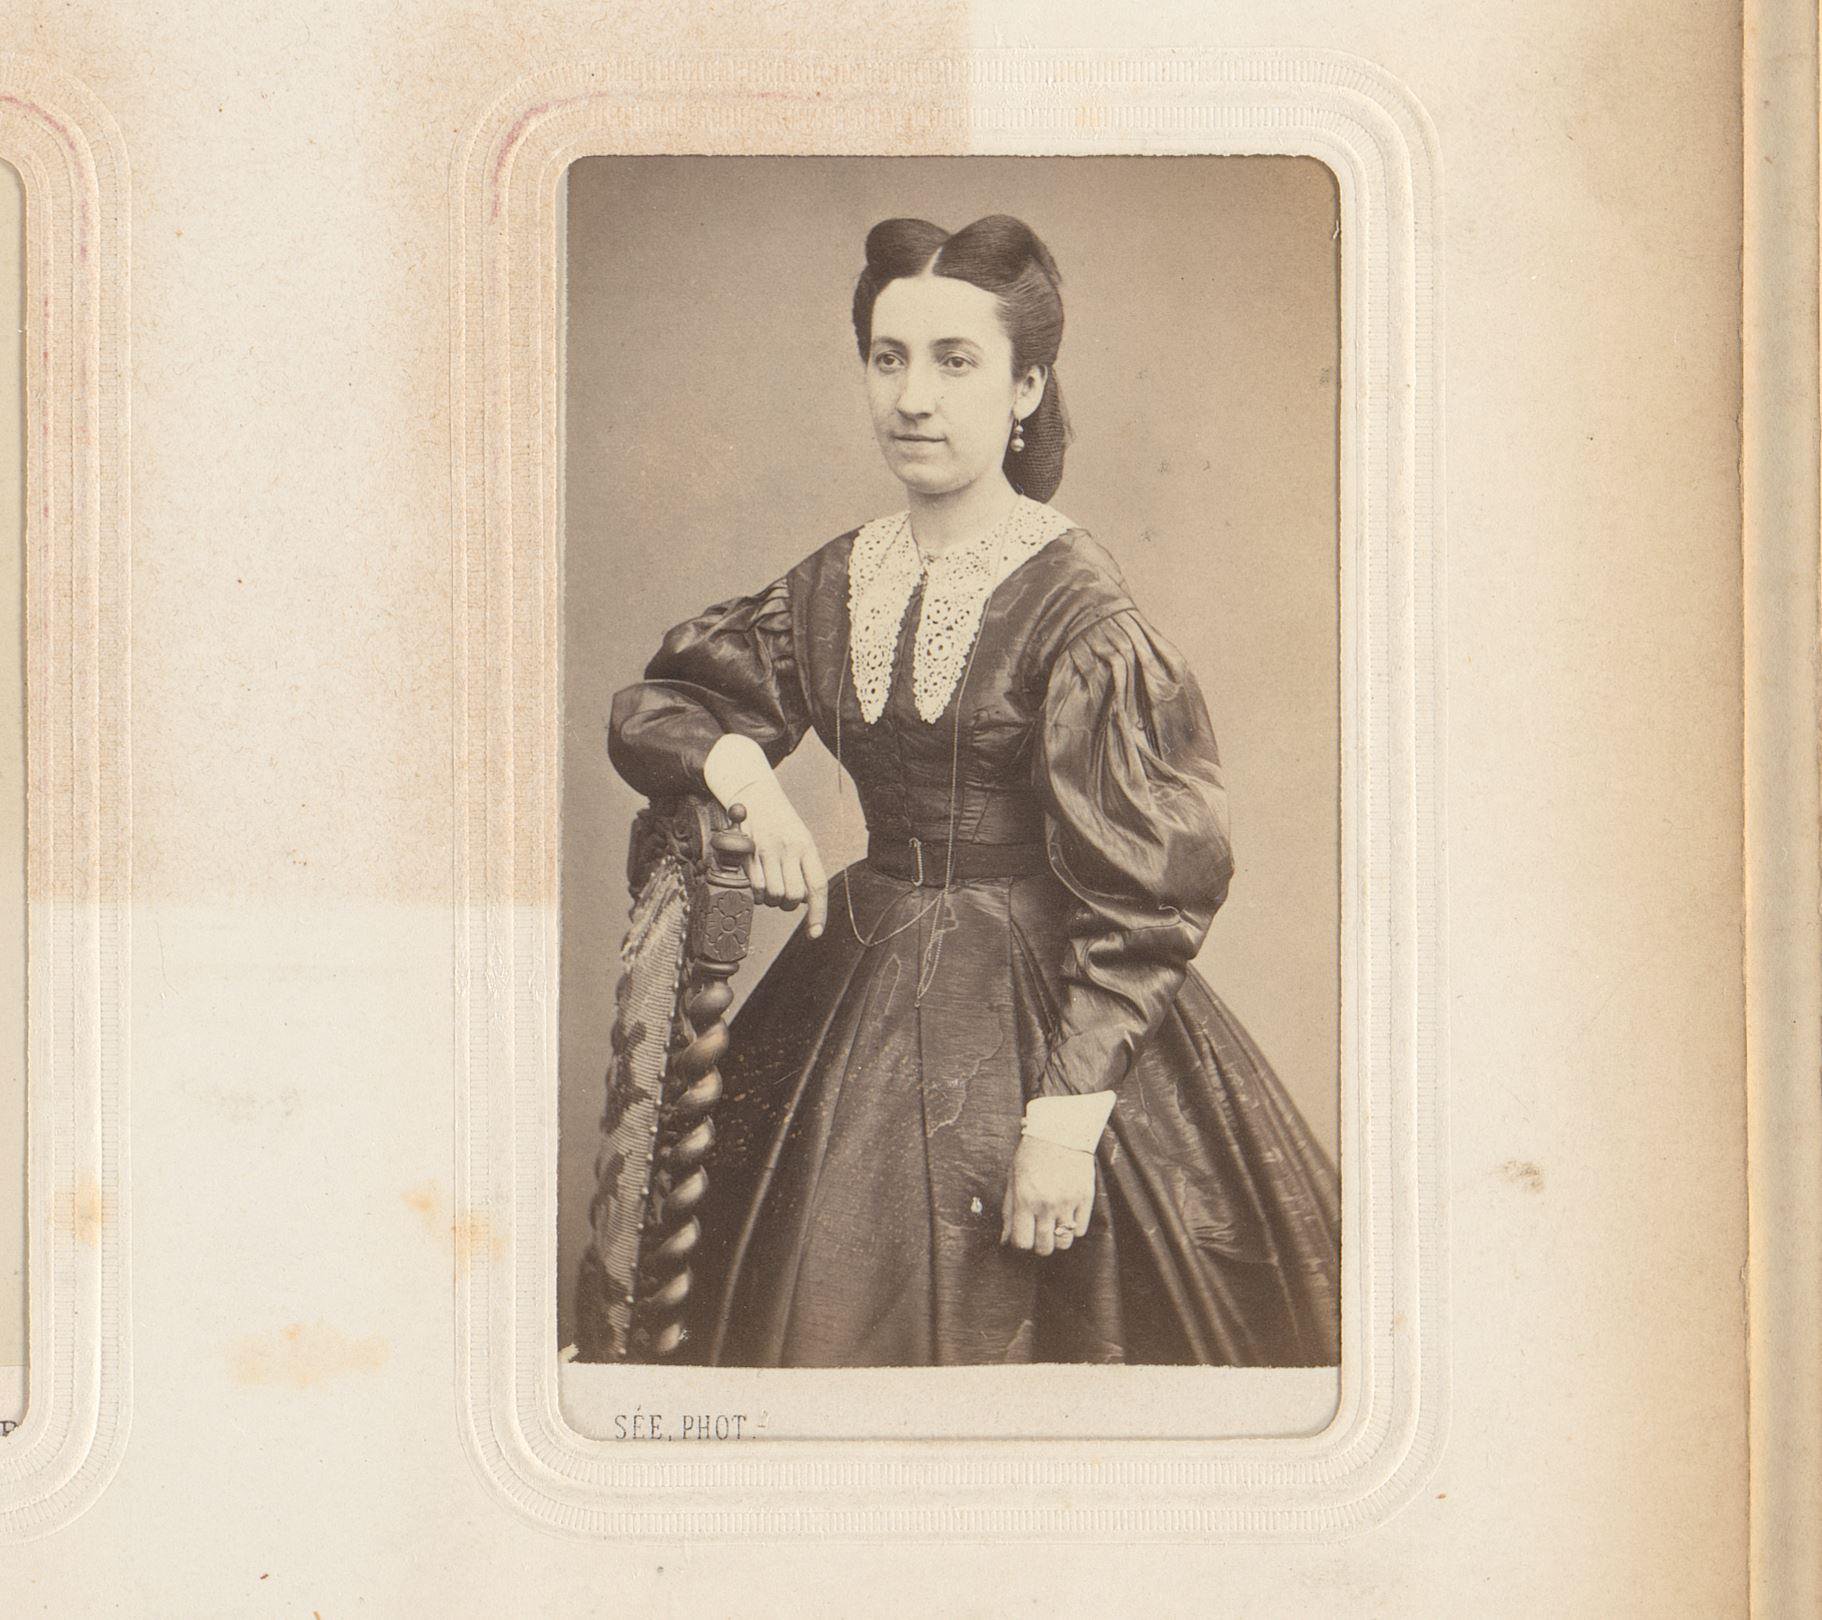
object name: carte de visite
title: Portret van een vrouw, leunend over de rugleuning van een stoel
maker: gerson sée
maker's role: fotograaf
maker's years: 1823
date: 1862-1865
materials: cardboard, paper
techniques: albumen print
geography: paris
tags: historical persons - bb - woman, chair